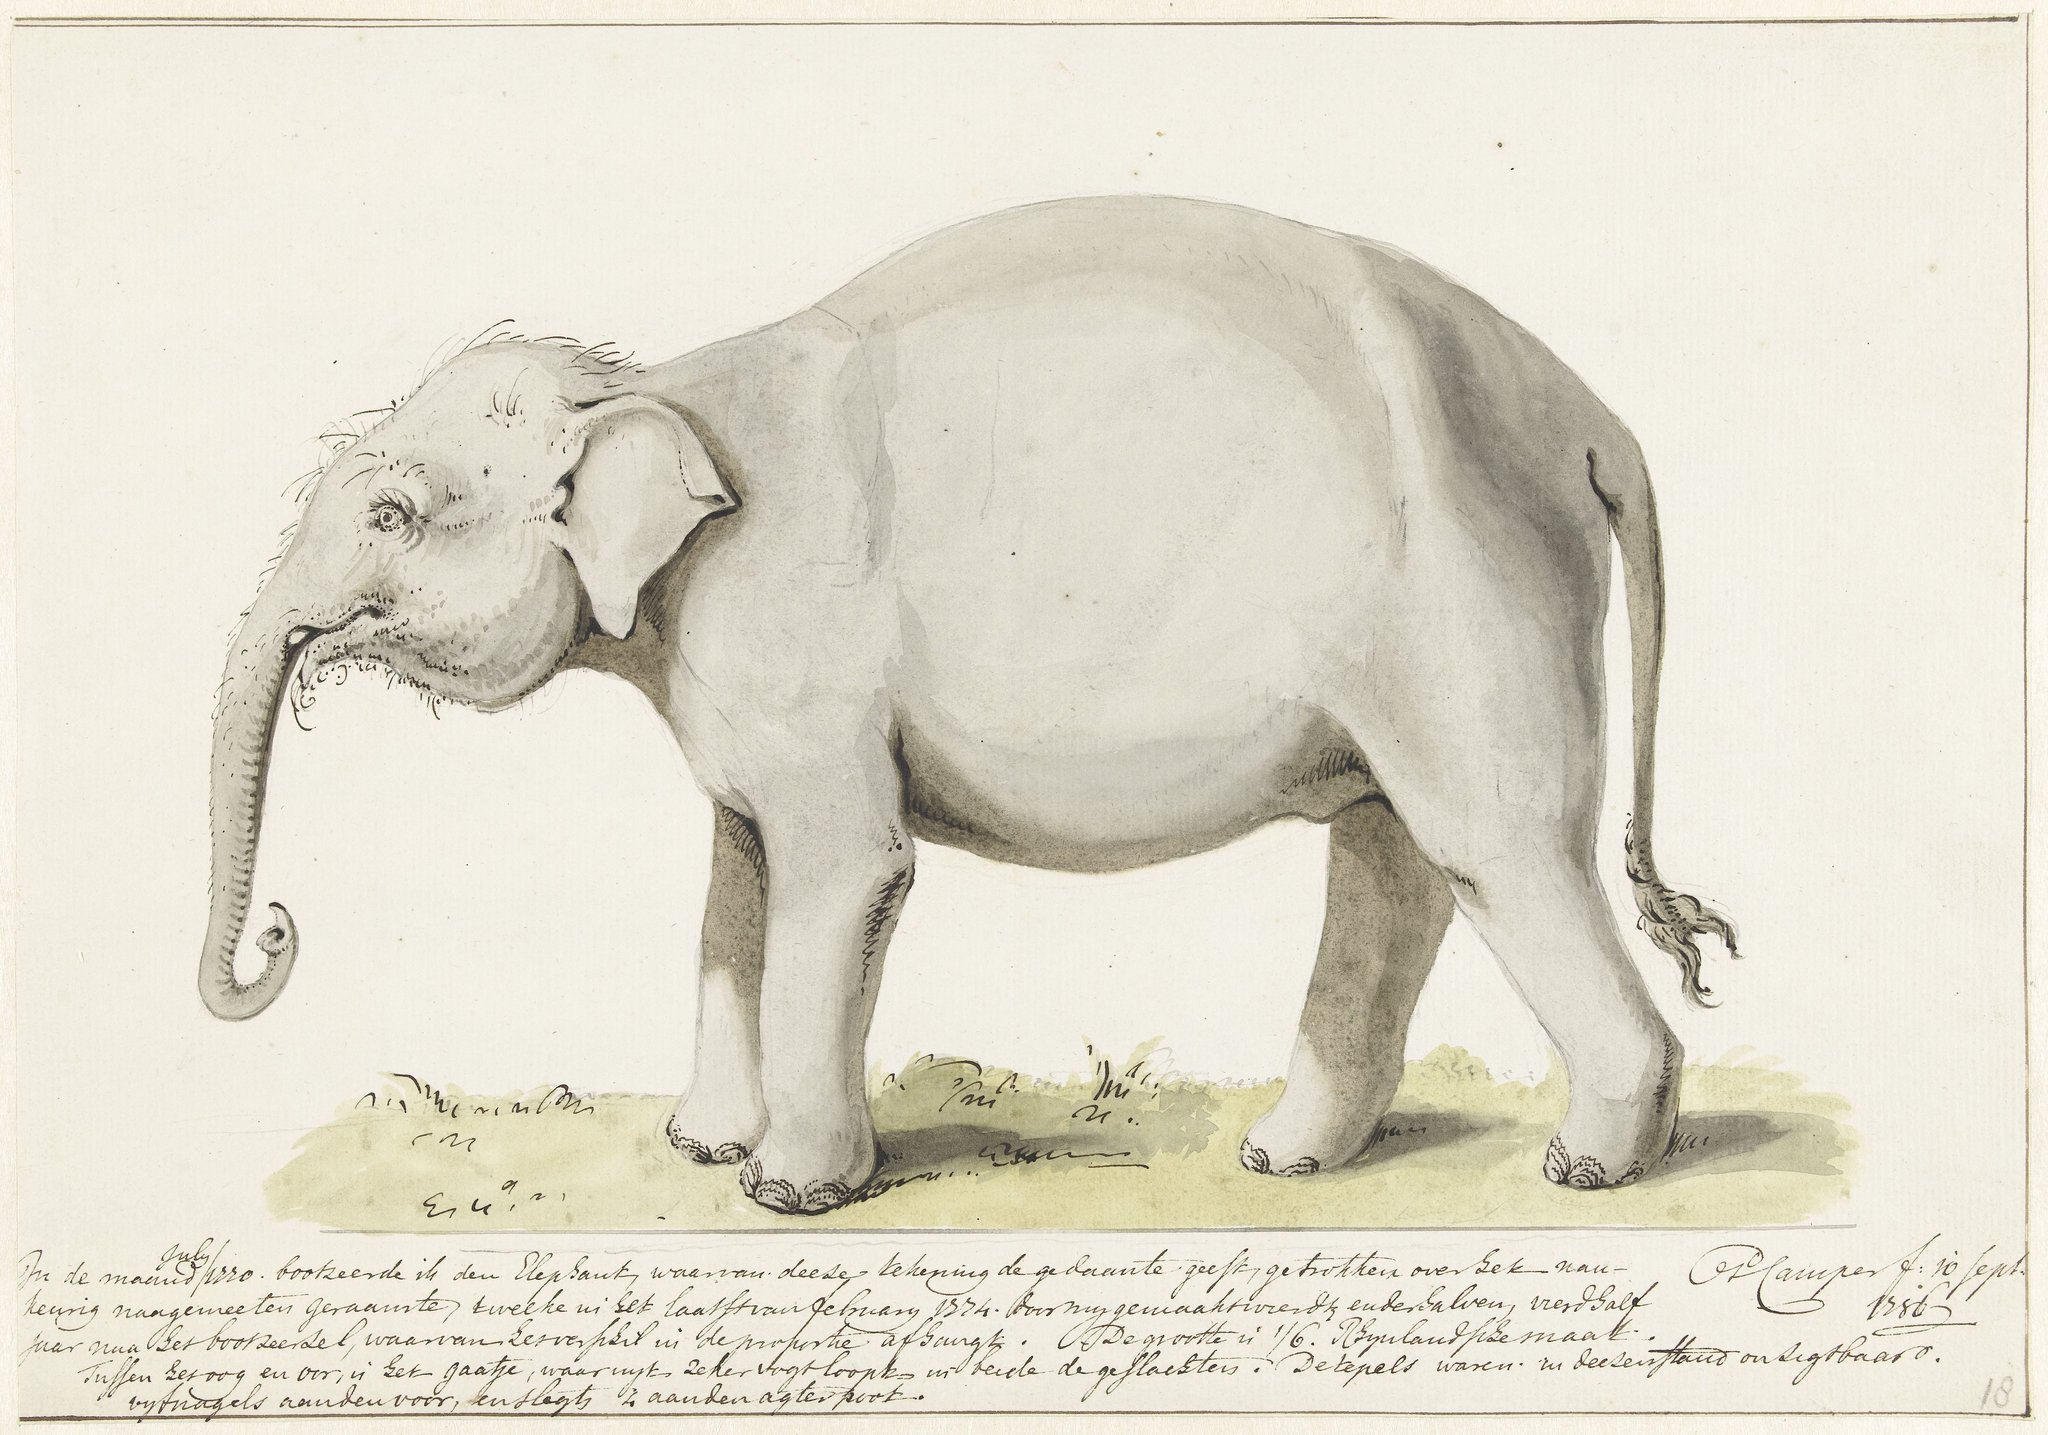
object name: drawing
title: Staande olifant, naar links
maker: petrus camper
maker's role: draughtsman, print maker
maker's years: 1722-1789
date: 1786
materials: ink, paper, pencil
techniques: brush, pen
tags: trunked animals: elephant